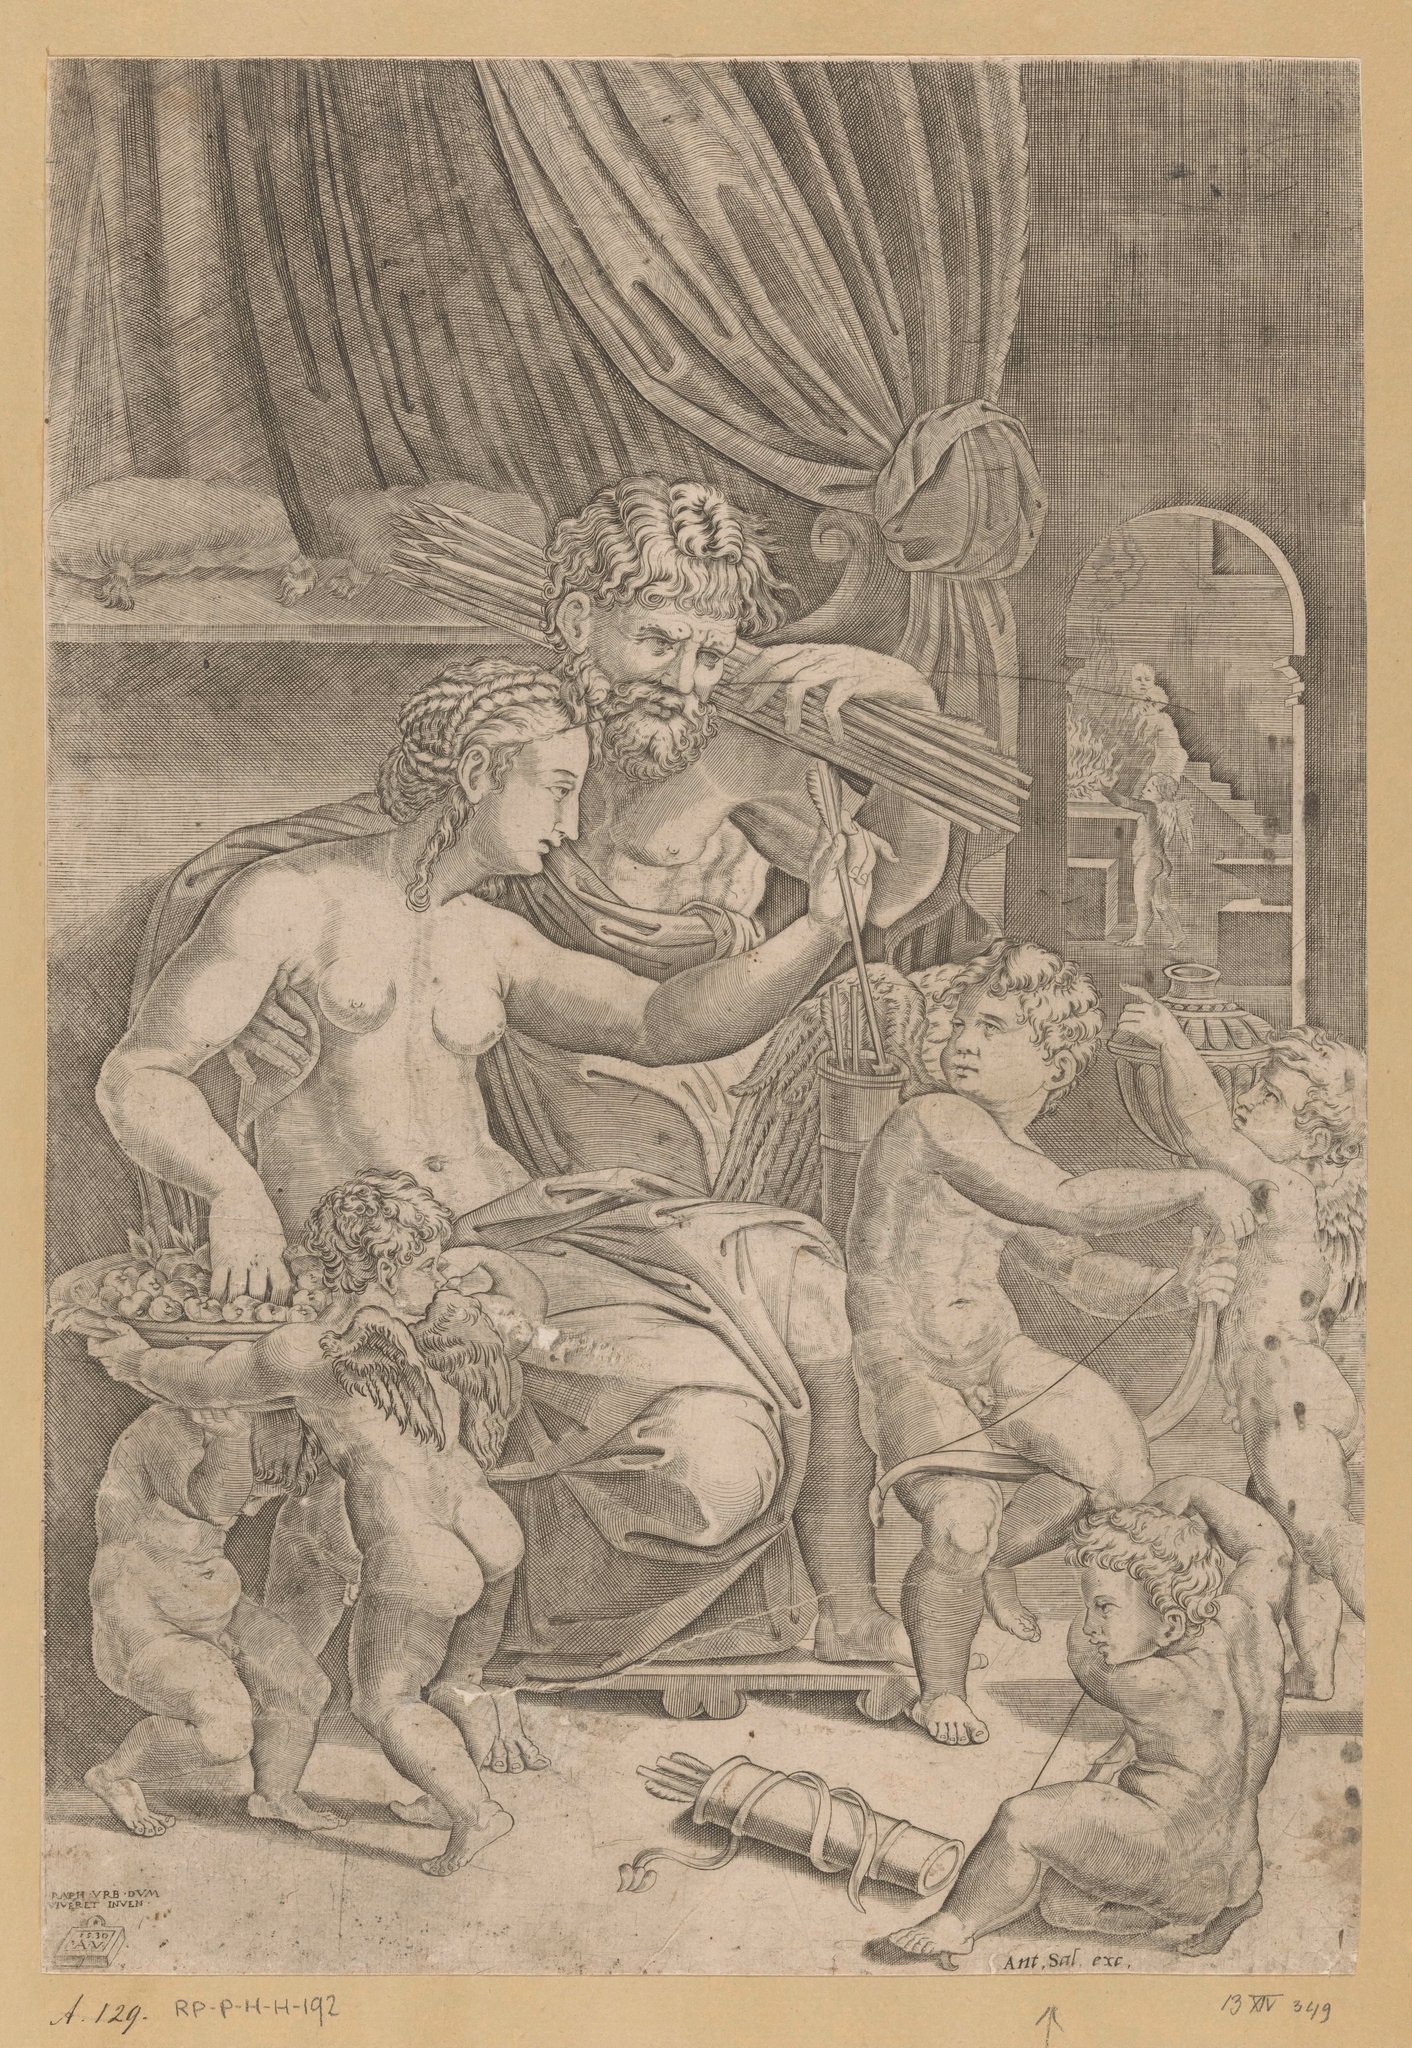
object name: print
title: Venus en Vulcanus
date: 1530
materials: paper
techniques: engraving, etching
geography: italy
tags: vulcan and venus, cupids: 'amores', 'amoretti', 'putti'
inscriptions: collector's mark: ‘Hinloopen’, collector's mark: Lugt 11, collector's mark: Lugt 10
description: Venus en Vulcanus zitten in een vertrek, achter hen een gordijn. Om hen heen vijf putti, waarvan twee bezig zijn een boog te spannen. Rechts op de achtergrond is door een deuropening de smidse zichtbaar.